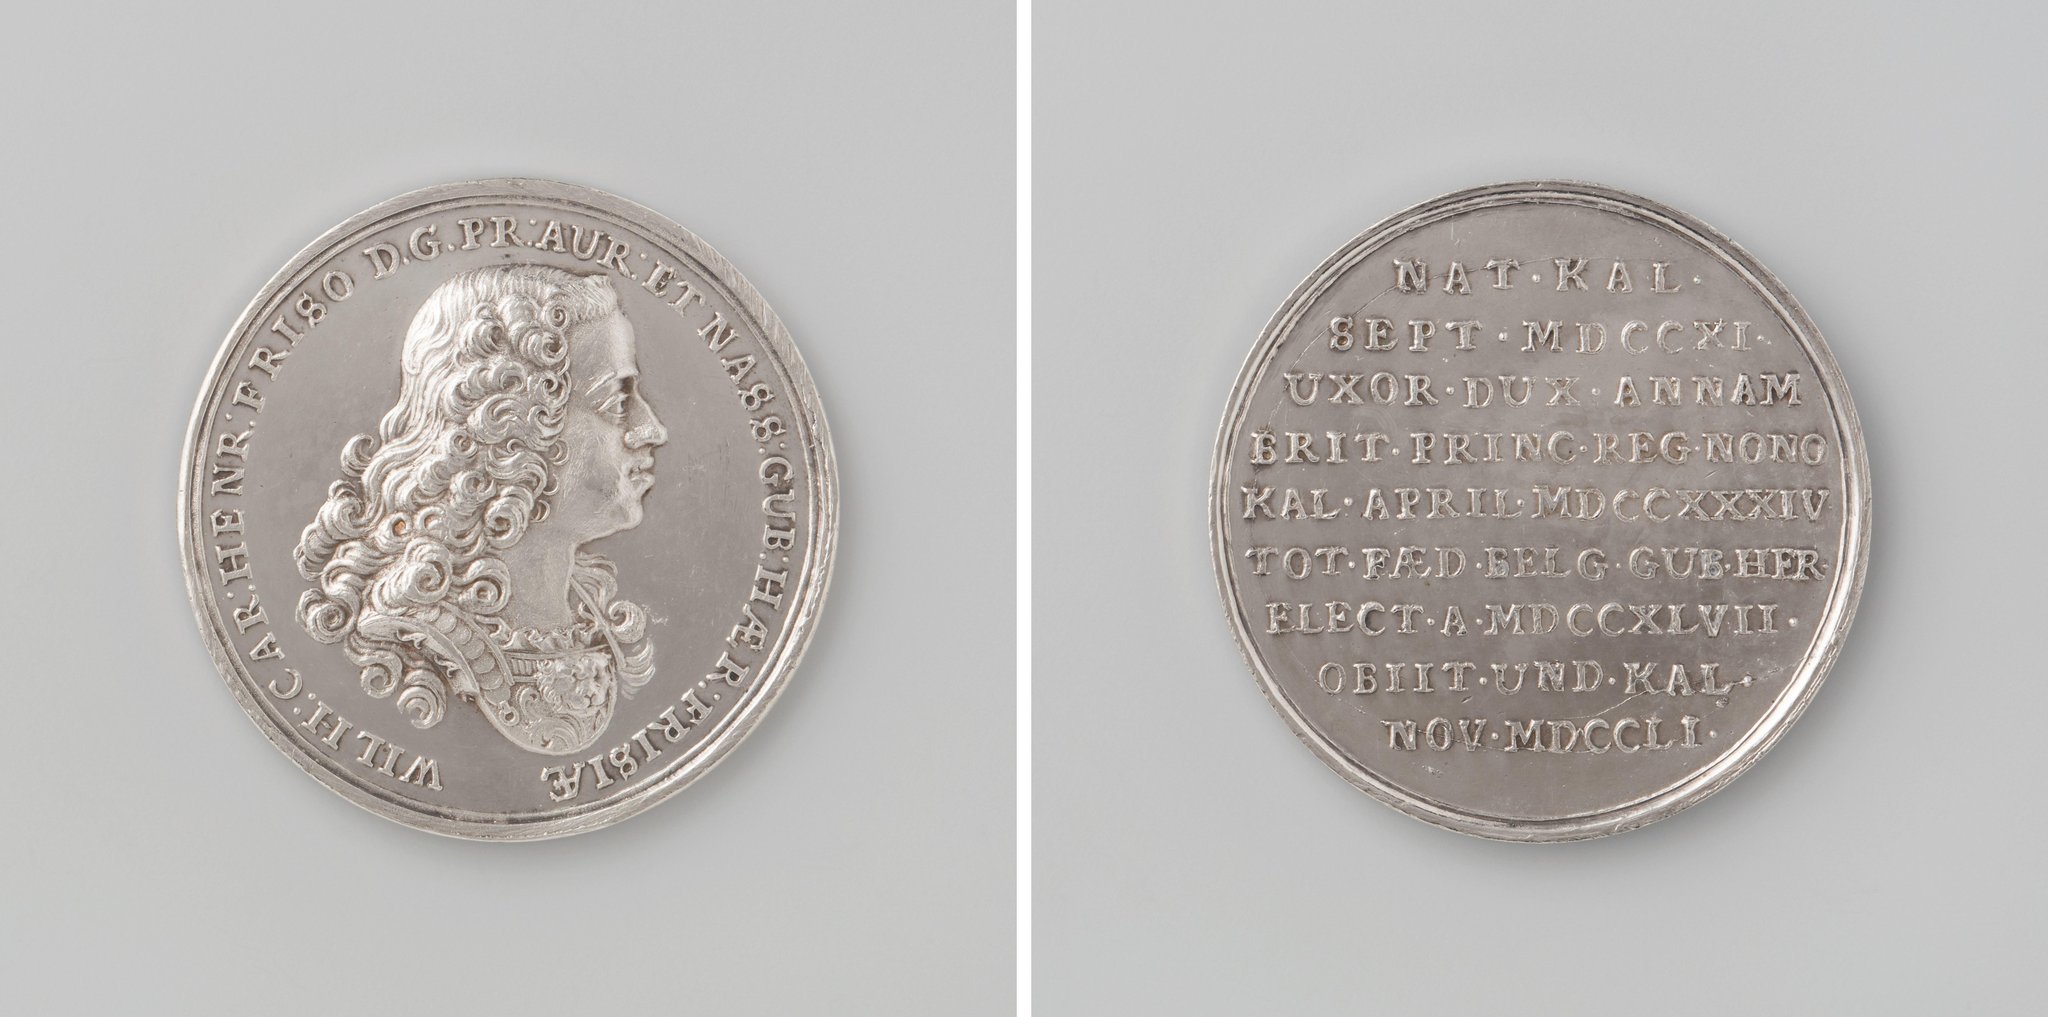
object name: history medal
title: Overlijden van Willem IV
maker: andele andeles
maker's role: medailleur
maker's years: 1687-1754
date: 1751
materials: silver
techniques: striking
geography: leeuwarden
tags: the hague, willem iv (prins van oranje-nassau)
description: Zilveren penning. Voorzijde: borststuk man binnen omschrift. Keerzijde: opschrift